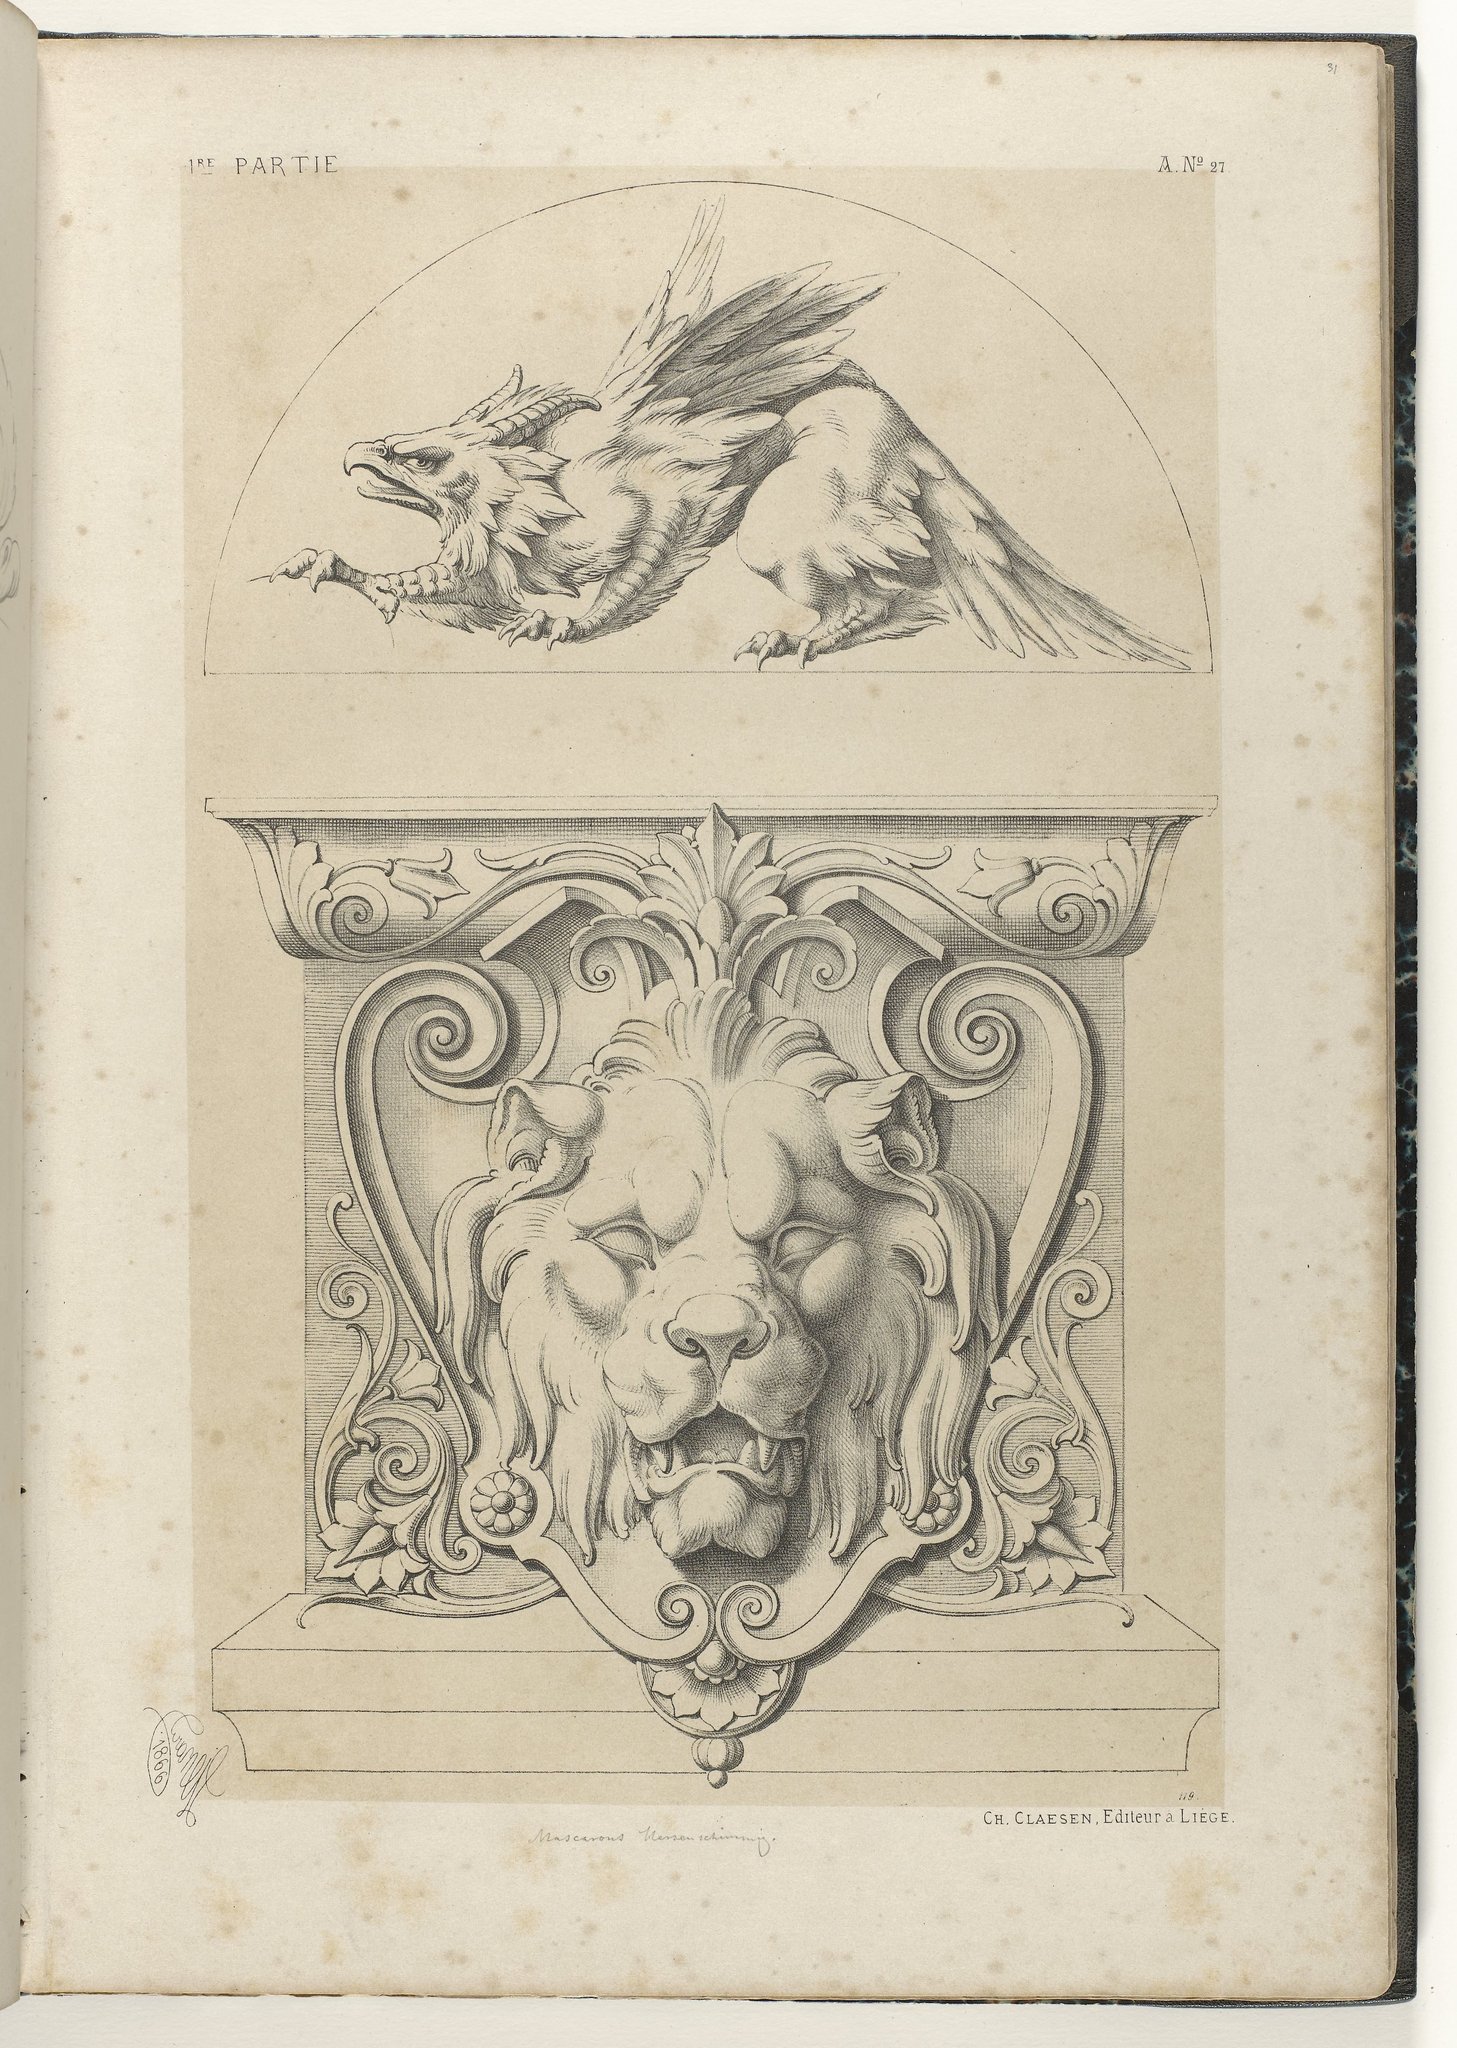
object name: print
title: Griffioen en schild met leeuwenkop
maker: michel liénard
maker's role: print maker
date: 1866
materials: paper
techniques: tone lithography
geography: liège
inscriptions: annotation: ‘Mascarons Hersenschimmig.’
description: Linksboven staat: 1re partie, rechtsboven: A. N° 27., rechtsonder: 119.